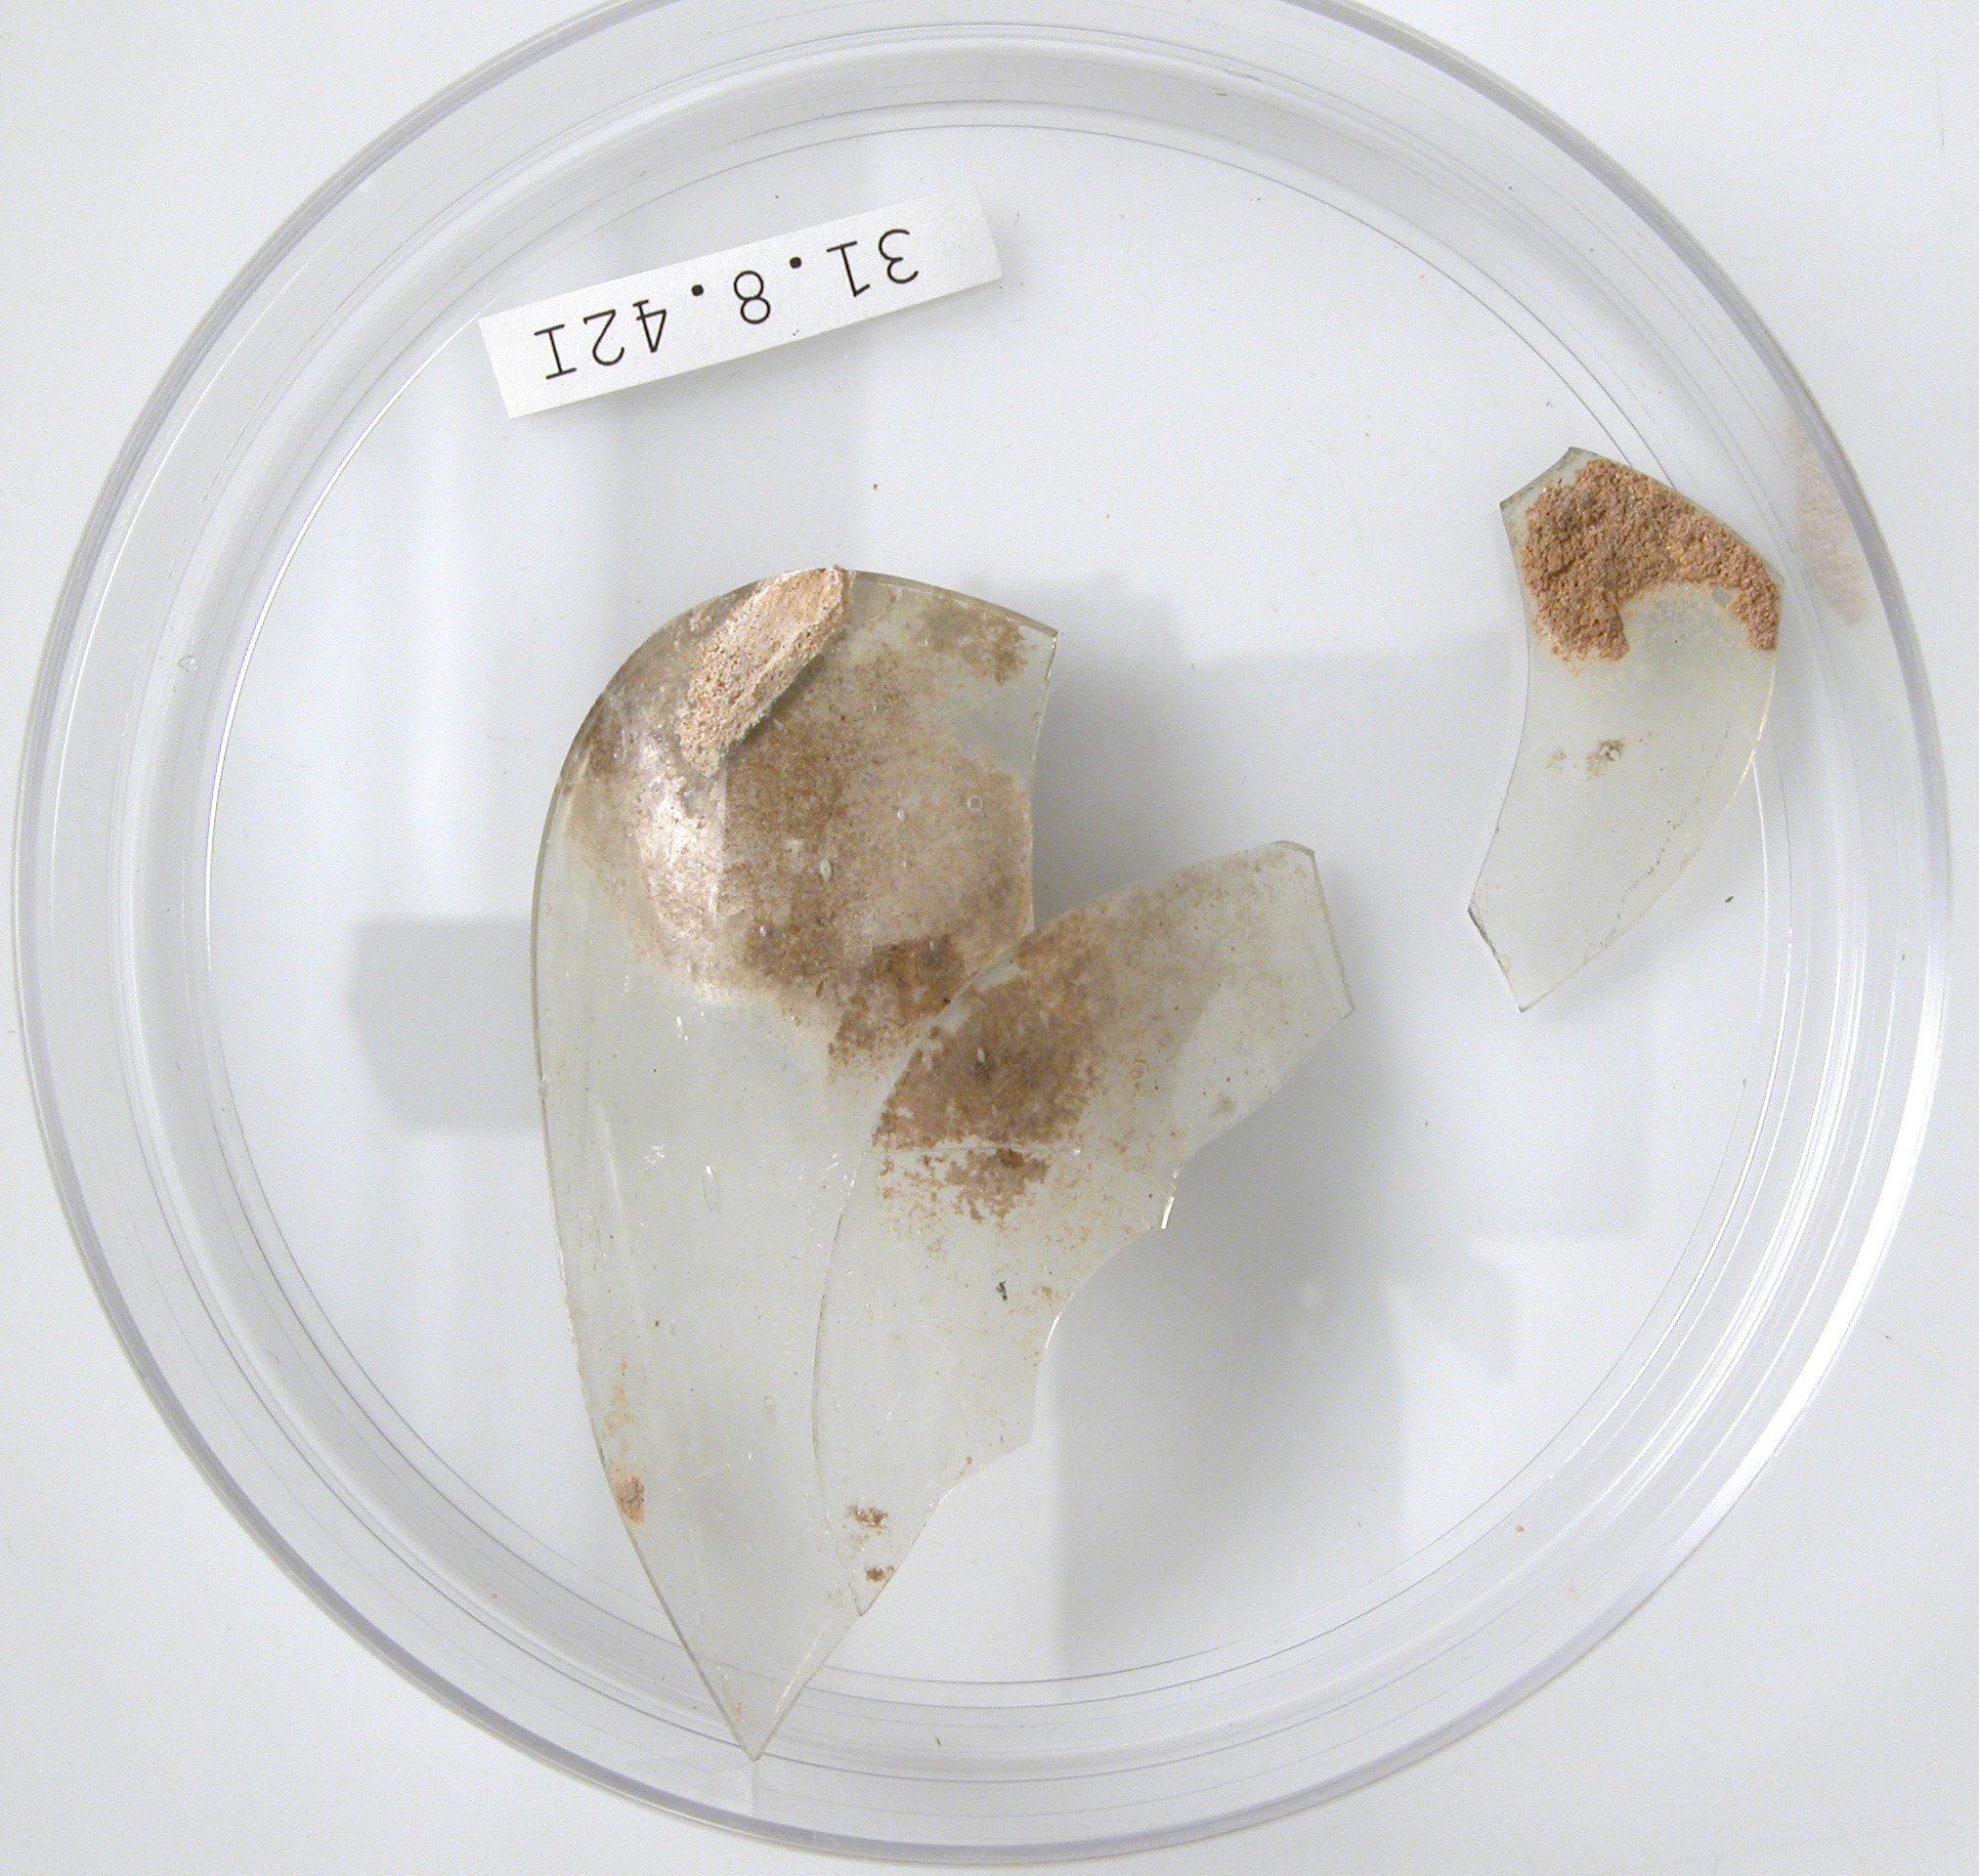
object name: fragment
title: Glass Fragments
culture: coptic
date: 301-400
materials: glass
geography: egypt